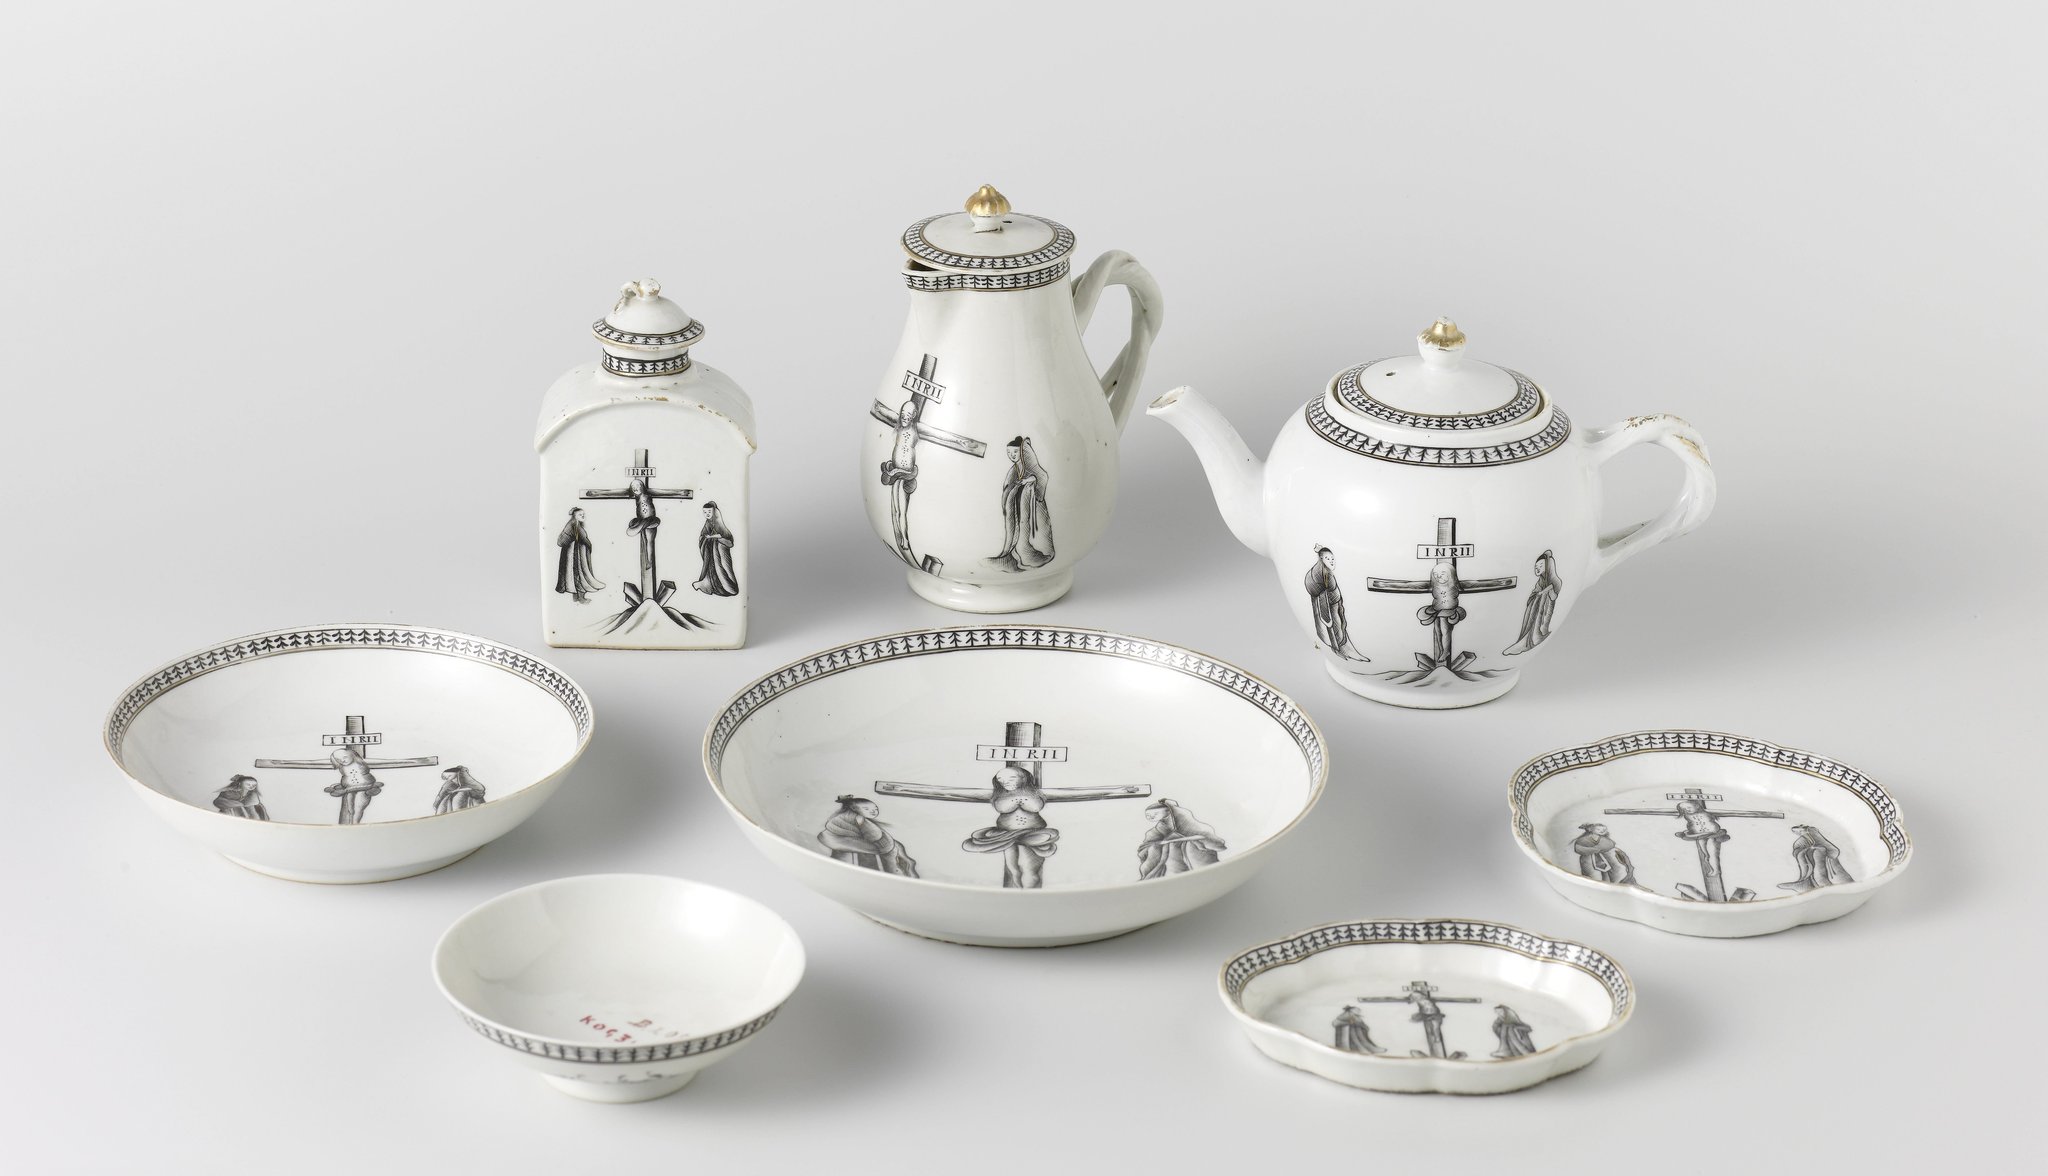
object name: tea service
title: Tea service with a crucifixion scene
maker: Anonymous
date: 1780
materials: glaze, gold, paint, porcelain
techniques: firing, gilding, turning, vitrification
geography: china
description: Episodes uit de Passiecyclus waren een populair onderwerp op Chine de commande. Vanaf de eerste jaren van de 18de eeuw bestonden er exemplaren in onderglazuur blauw met religieuze scènes. Rond 1740 is er een grote productie geweest van encre de Chine. Uit vermeldingen in het VOC archief blijkt dat dit servies werd besteld in opdracht van de VOC en in 1779 naar Nederland werd verscheept in. In totaal werden tweeëntwintig serviezen geleverd. Wanneer we kijken naar de magere kwaliteit van het schilderwerk, zeker in vergelijking met vroegere exemplaren, is het niet verwonderlijk dat de directeuren van de VOC in het geheel niet tevreden waren met dit resultaat.